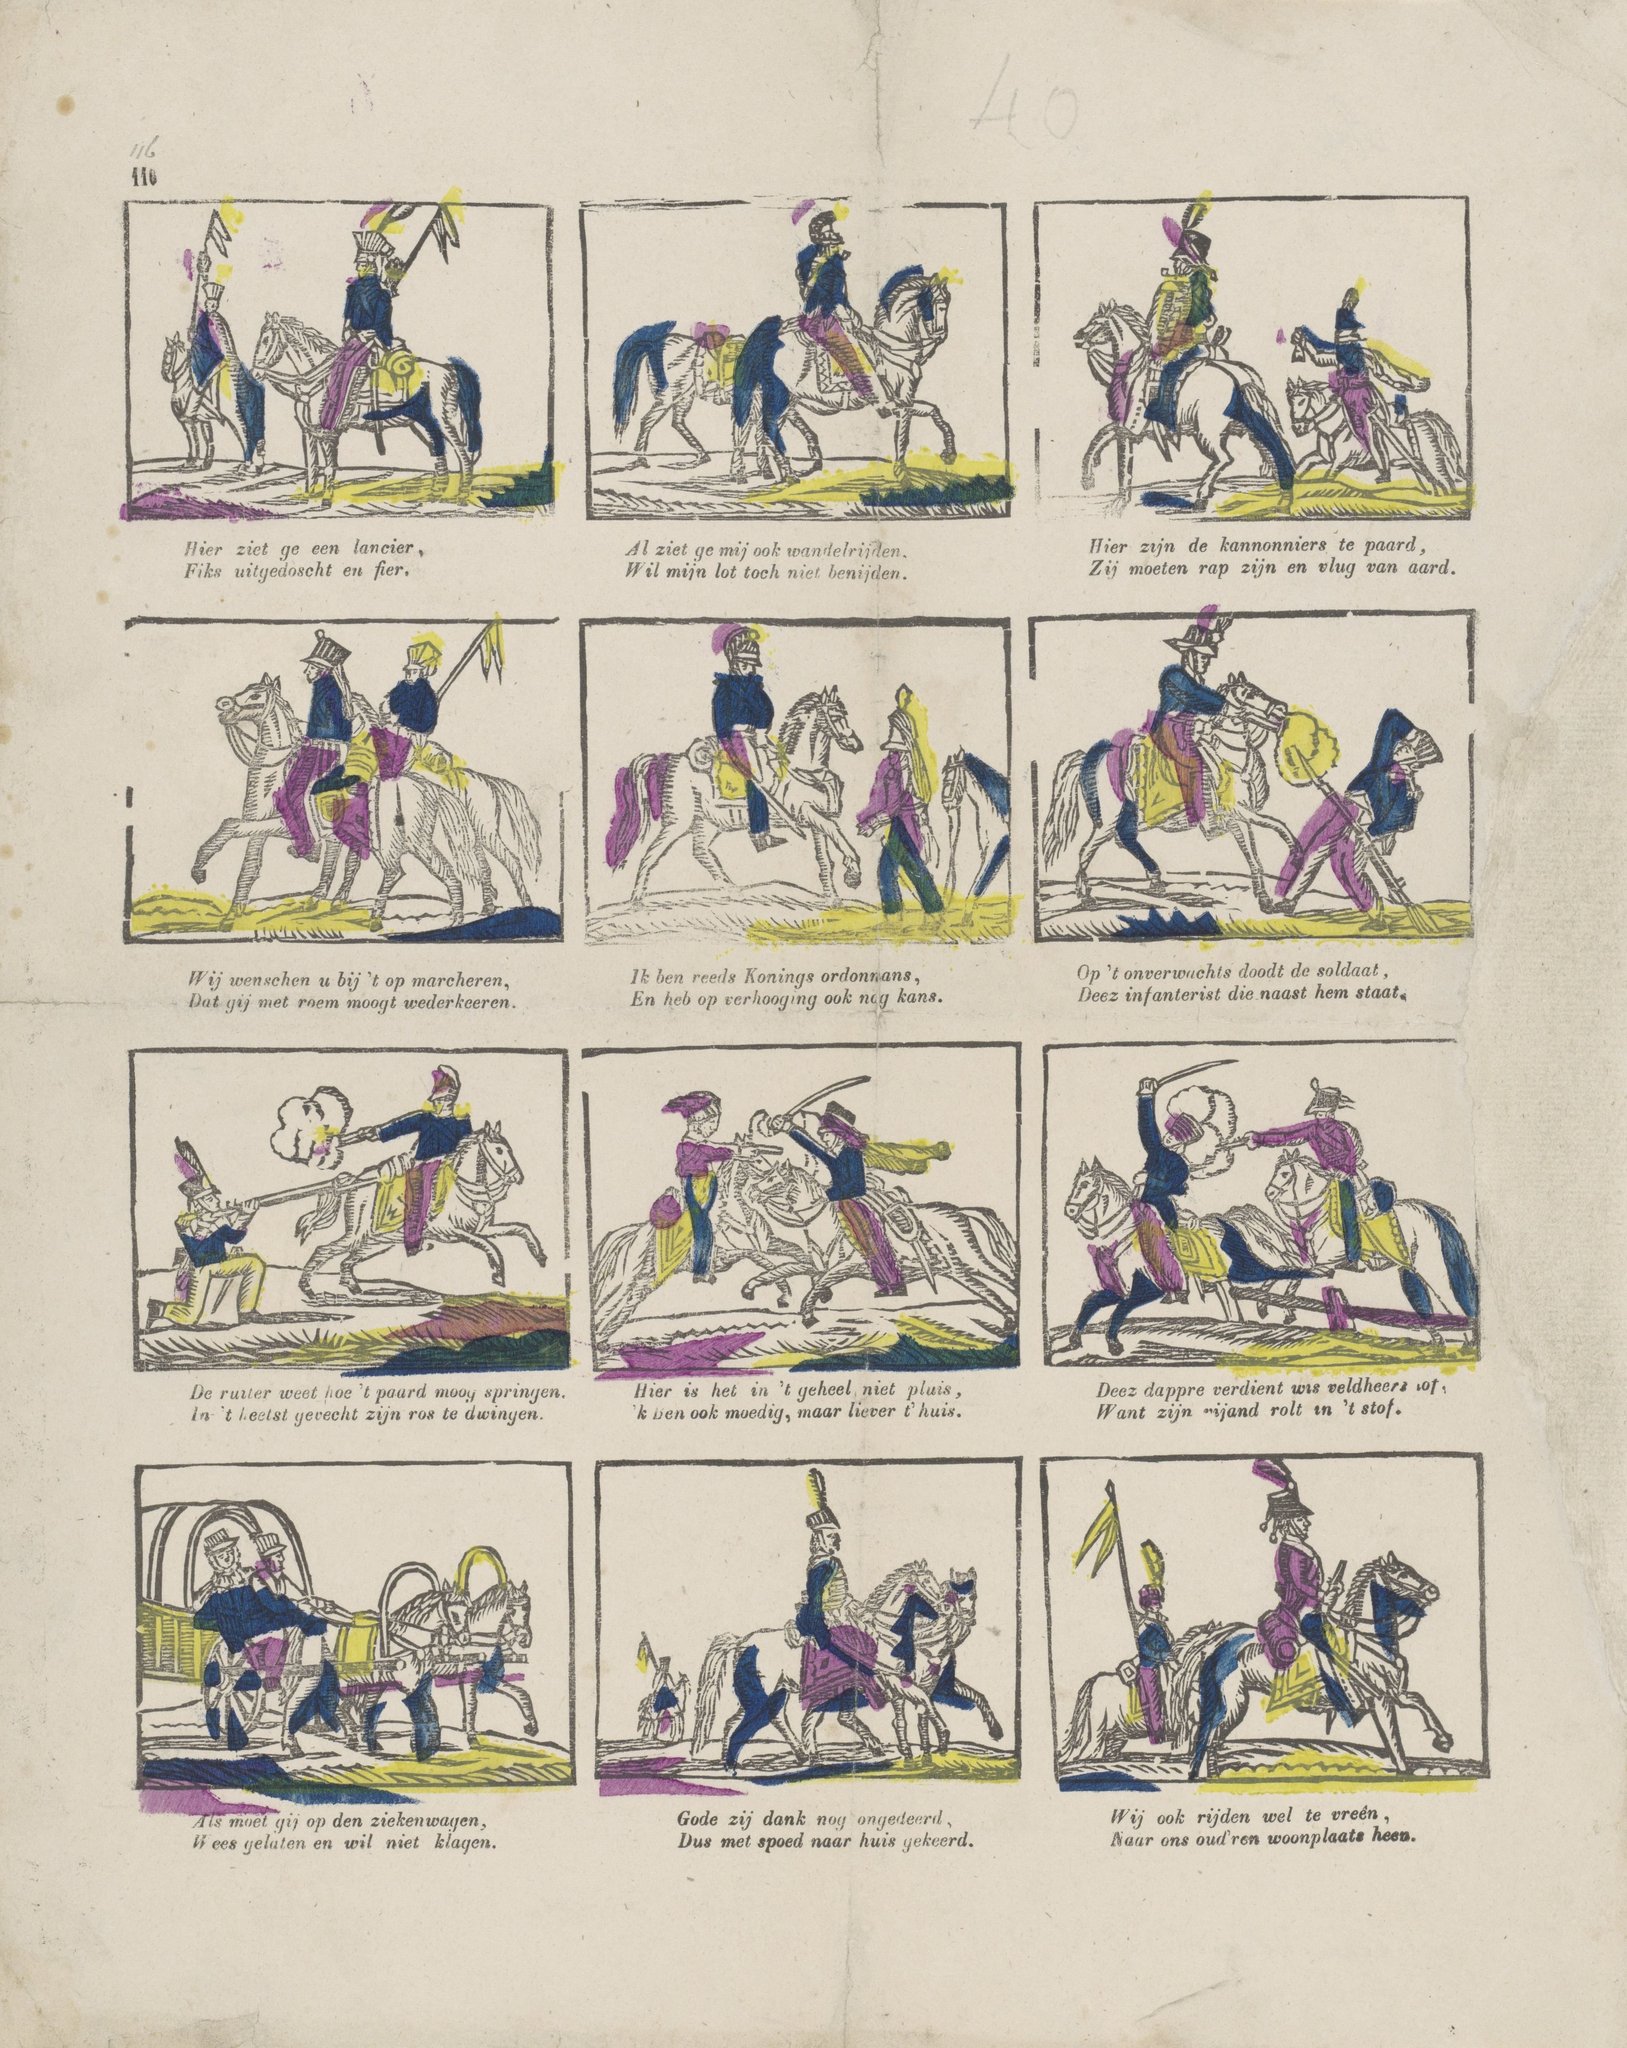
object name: print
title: Militairen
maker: Anonymous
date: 1848-1881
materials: paper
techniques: colour, letterpress printing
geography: netherlands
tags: warfare; military affairs (+ cavalry, horsemen), the soldier; the soldier's life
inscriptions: collector's mark: Lugt 2760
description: Blad met 12 voorstellingen van militairen te paard. Onder elke voorstelling een tweeregelig vers. Genummerd linksboven: 116.